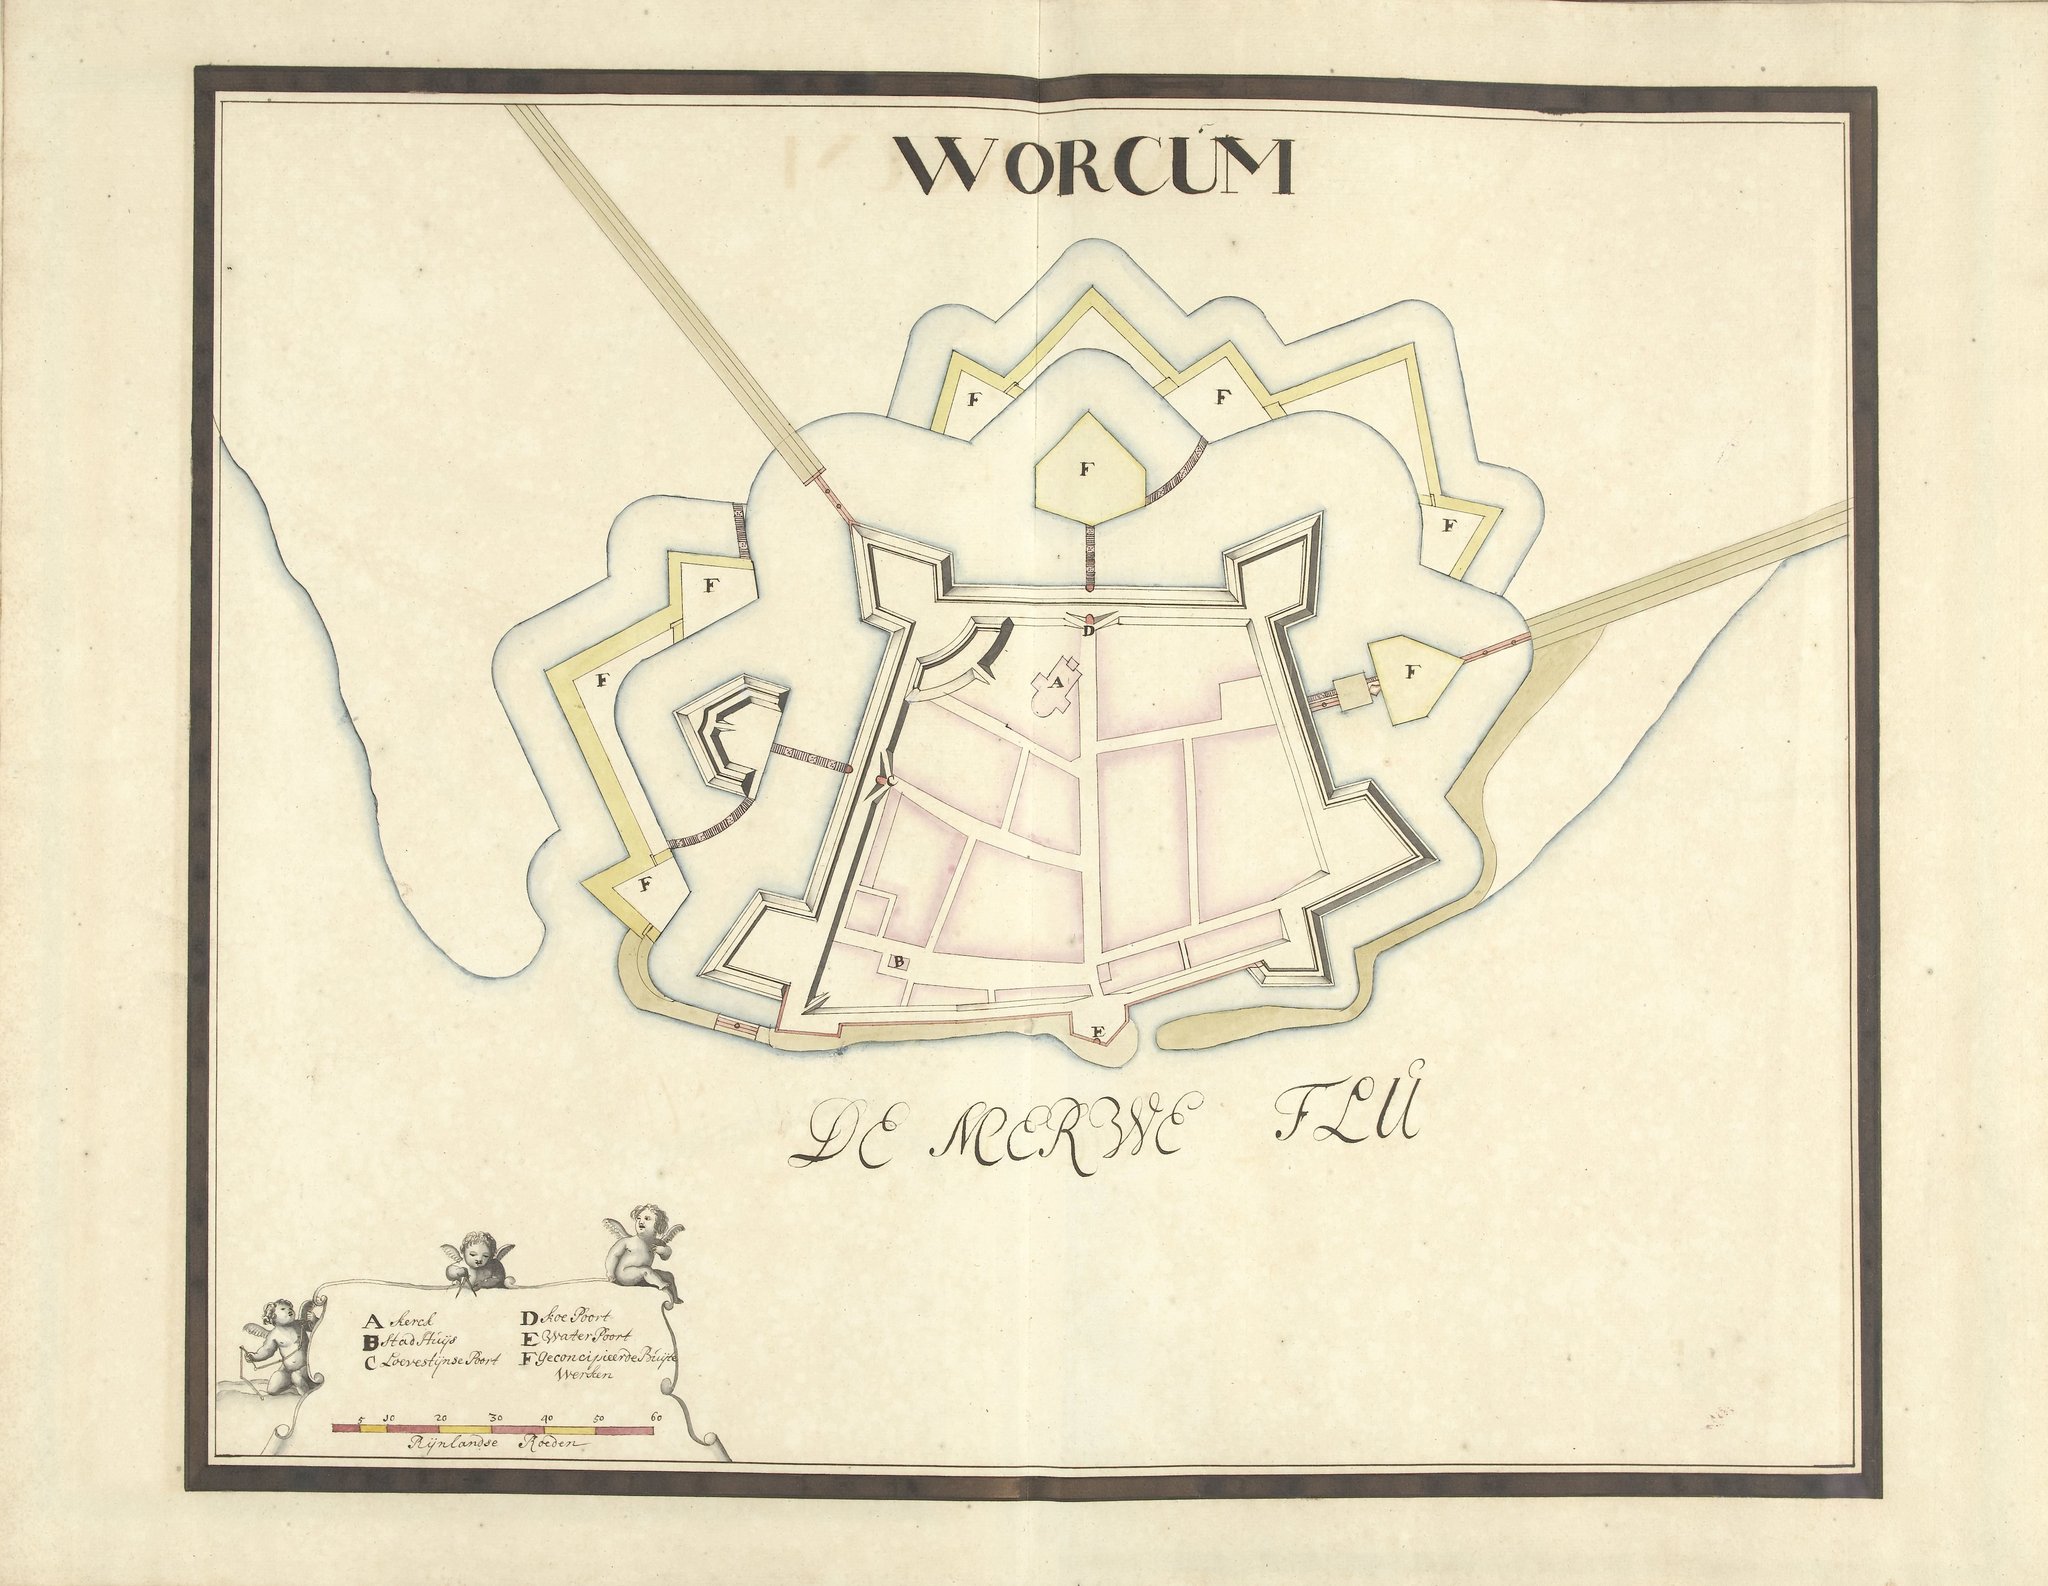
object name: map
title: Worcum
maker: samuel du ry de champdoré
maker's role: draughtsman, engineer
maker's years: 1651-1729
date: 1701-1715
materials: paper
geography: netherlands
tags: fortress, maps of cities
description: Plattegrond van de versterkingen om de stad Workum, ca. 1701-1715. Linksonder een cartouche met de legenda A-F in het Nederlands, met drie putti met passer en meetlint. Onderdeel van een verzameling getekende plannen van versterkte plaatsen in Nederland en omringende landen ten tijde van de Spaanse Successieoorlog (deel A).